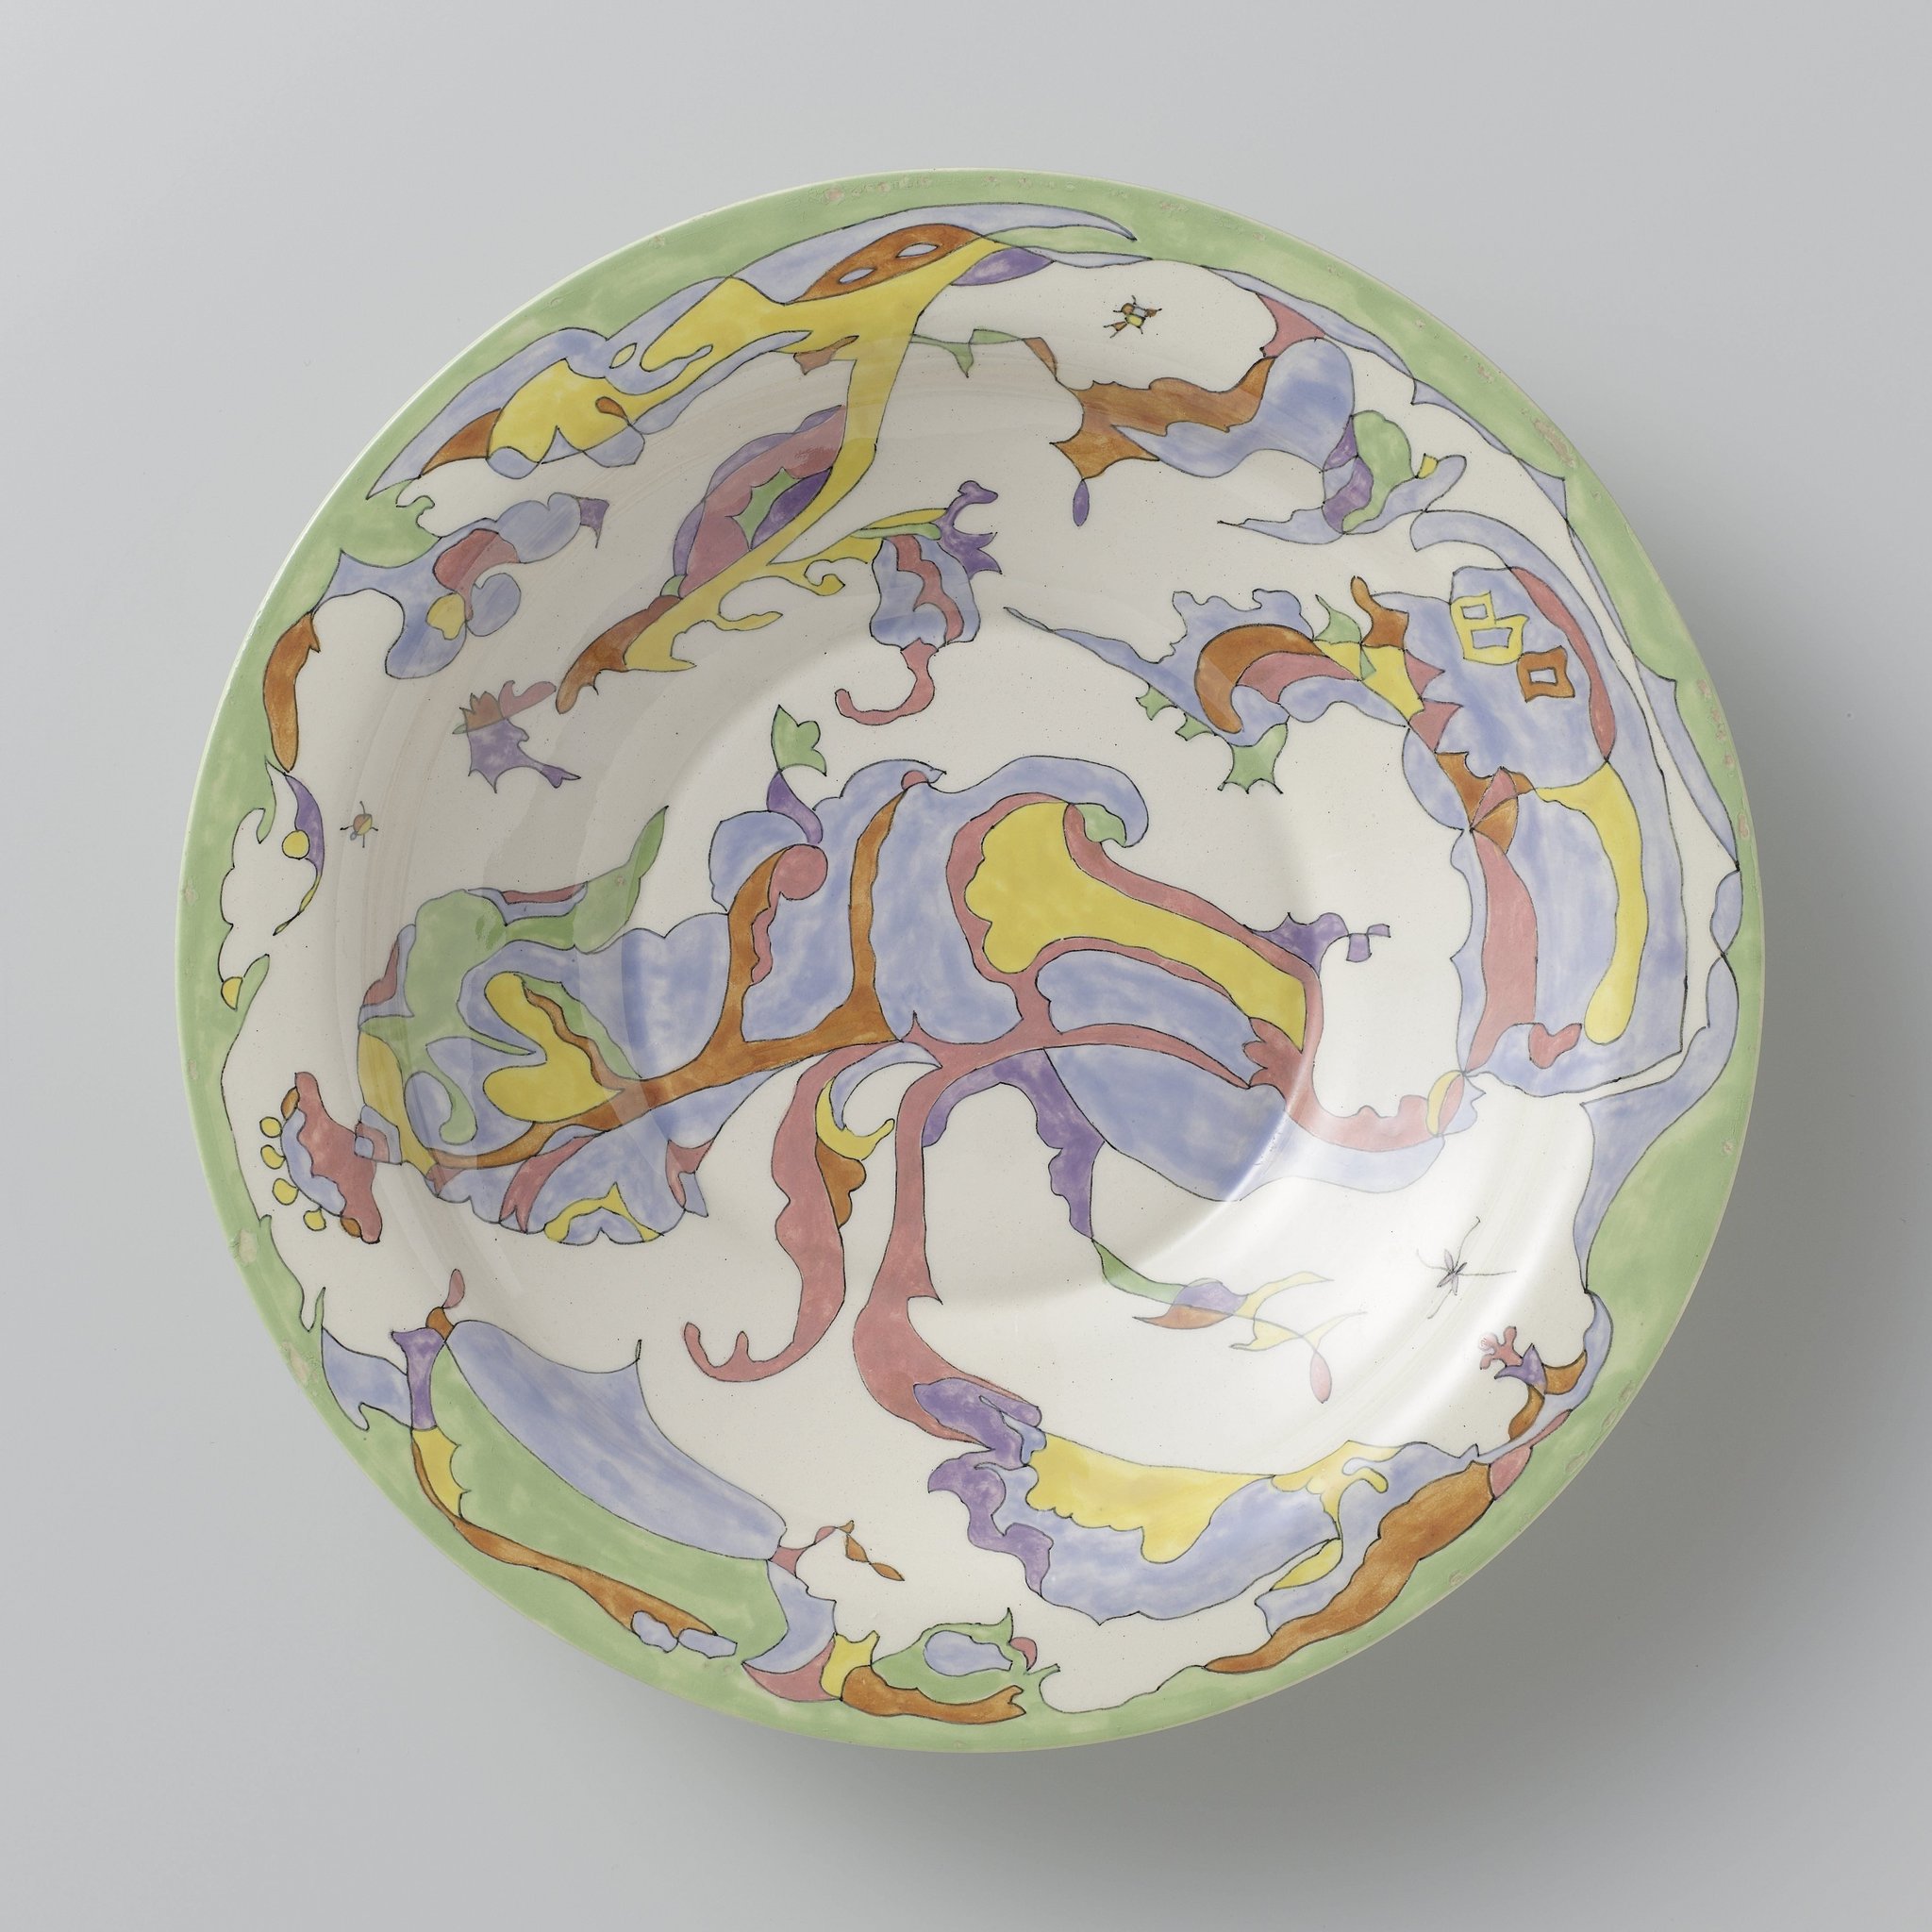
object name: plate dish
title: Bord van aardewerk, beschilderd met het patroon "Los"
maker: theo colenbrander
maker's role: draughtsman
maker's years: 1841-1930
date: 1925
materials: earthenware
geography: arnhem